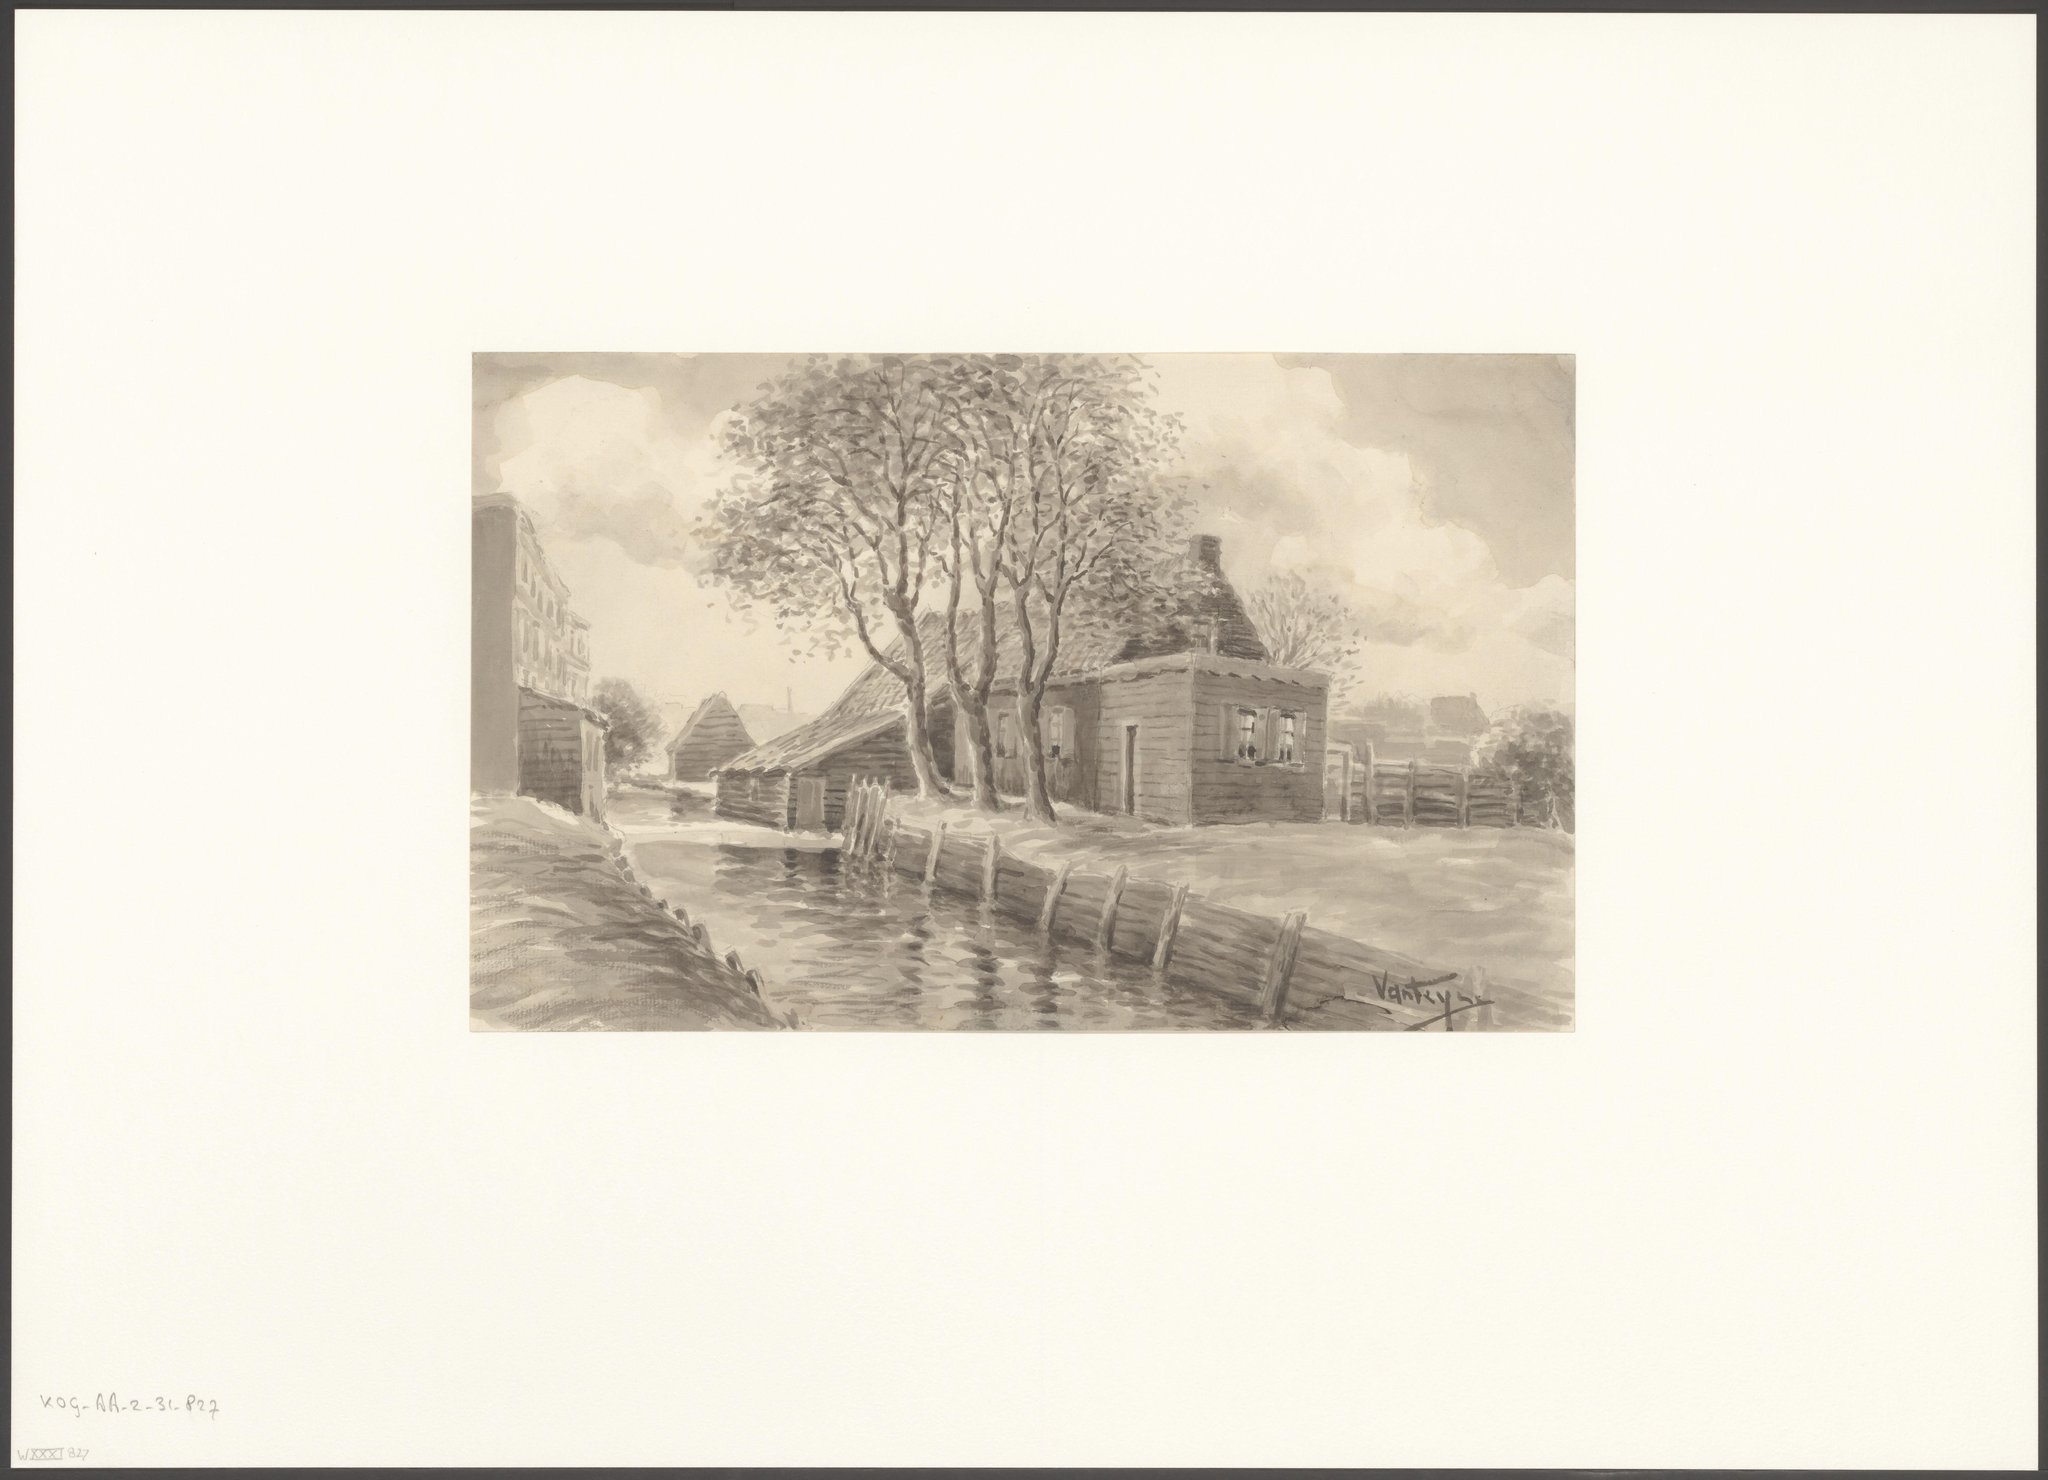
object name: drawing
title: Gezicht op een kanaaltje nabij de Albert Neuhuysstraat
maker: anthonie van teijn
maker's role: draughtsman, painter, print maker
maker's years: 1863-1943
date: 1910-1927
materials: ink, paper, pencil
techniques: brush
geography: amsterdam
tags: city-view in general; 'veduta', small canal, ditch, farm or solitary house in landscape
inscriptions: inscription: ‘Nabij de Albert Neuyhuisstraat. en Jacob Marisstr. Oct 1927 / vanEck’, signature: ‘VanTeyne’, collector's mark: Lugt 800a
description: Tekening binnen de Atlas Van Eck ingedeeld op wijknummer 31.